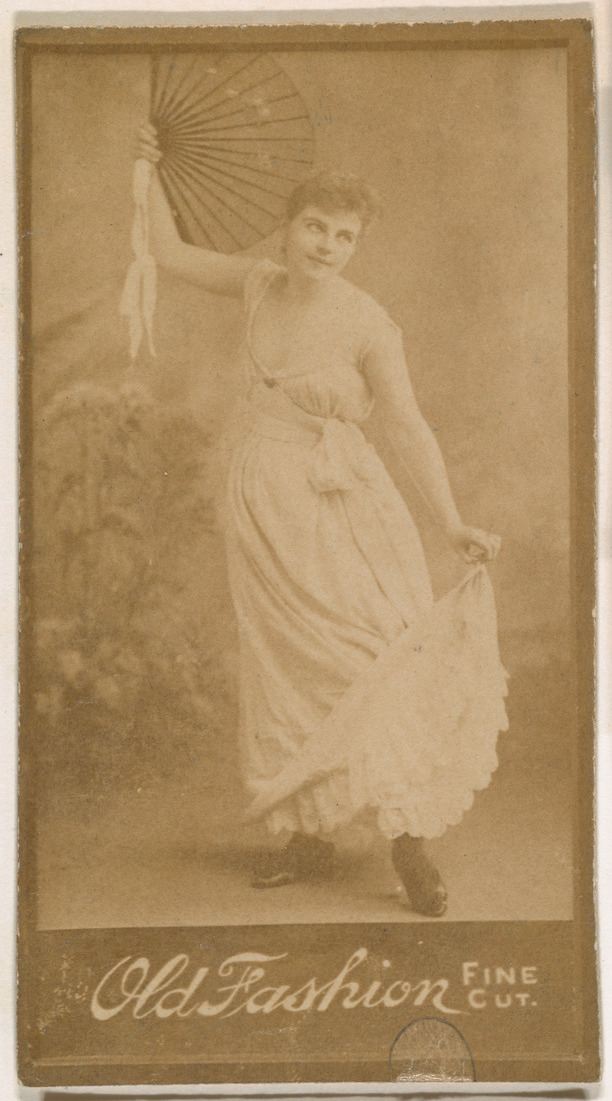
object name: photograph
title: Dancer holding fan, from the Actresses series (N664) promoting Old Fashion Fine Cut Tobacco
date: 1888-1890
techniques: albumen silver print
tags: portraits,women,actresses